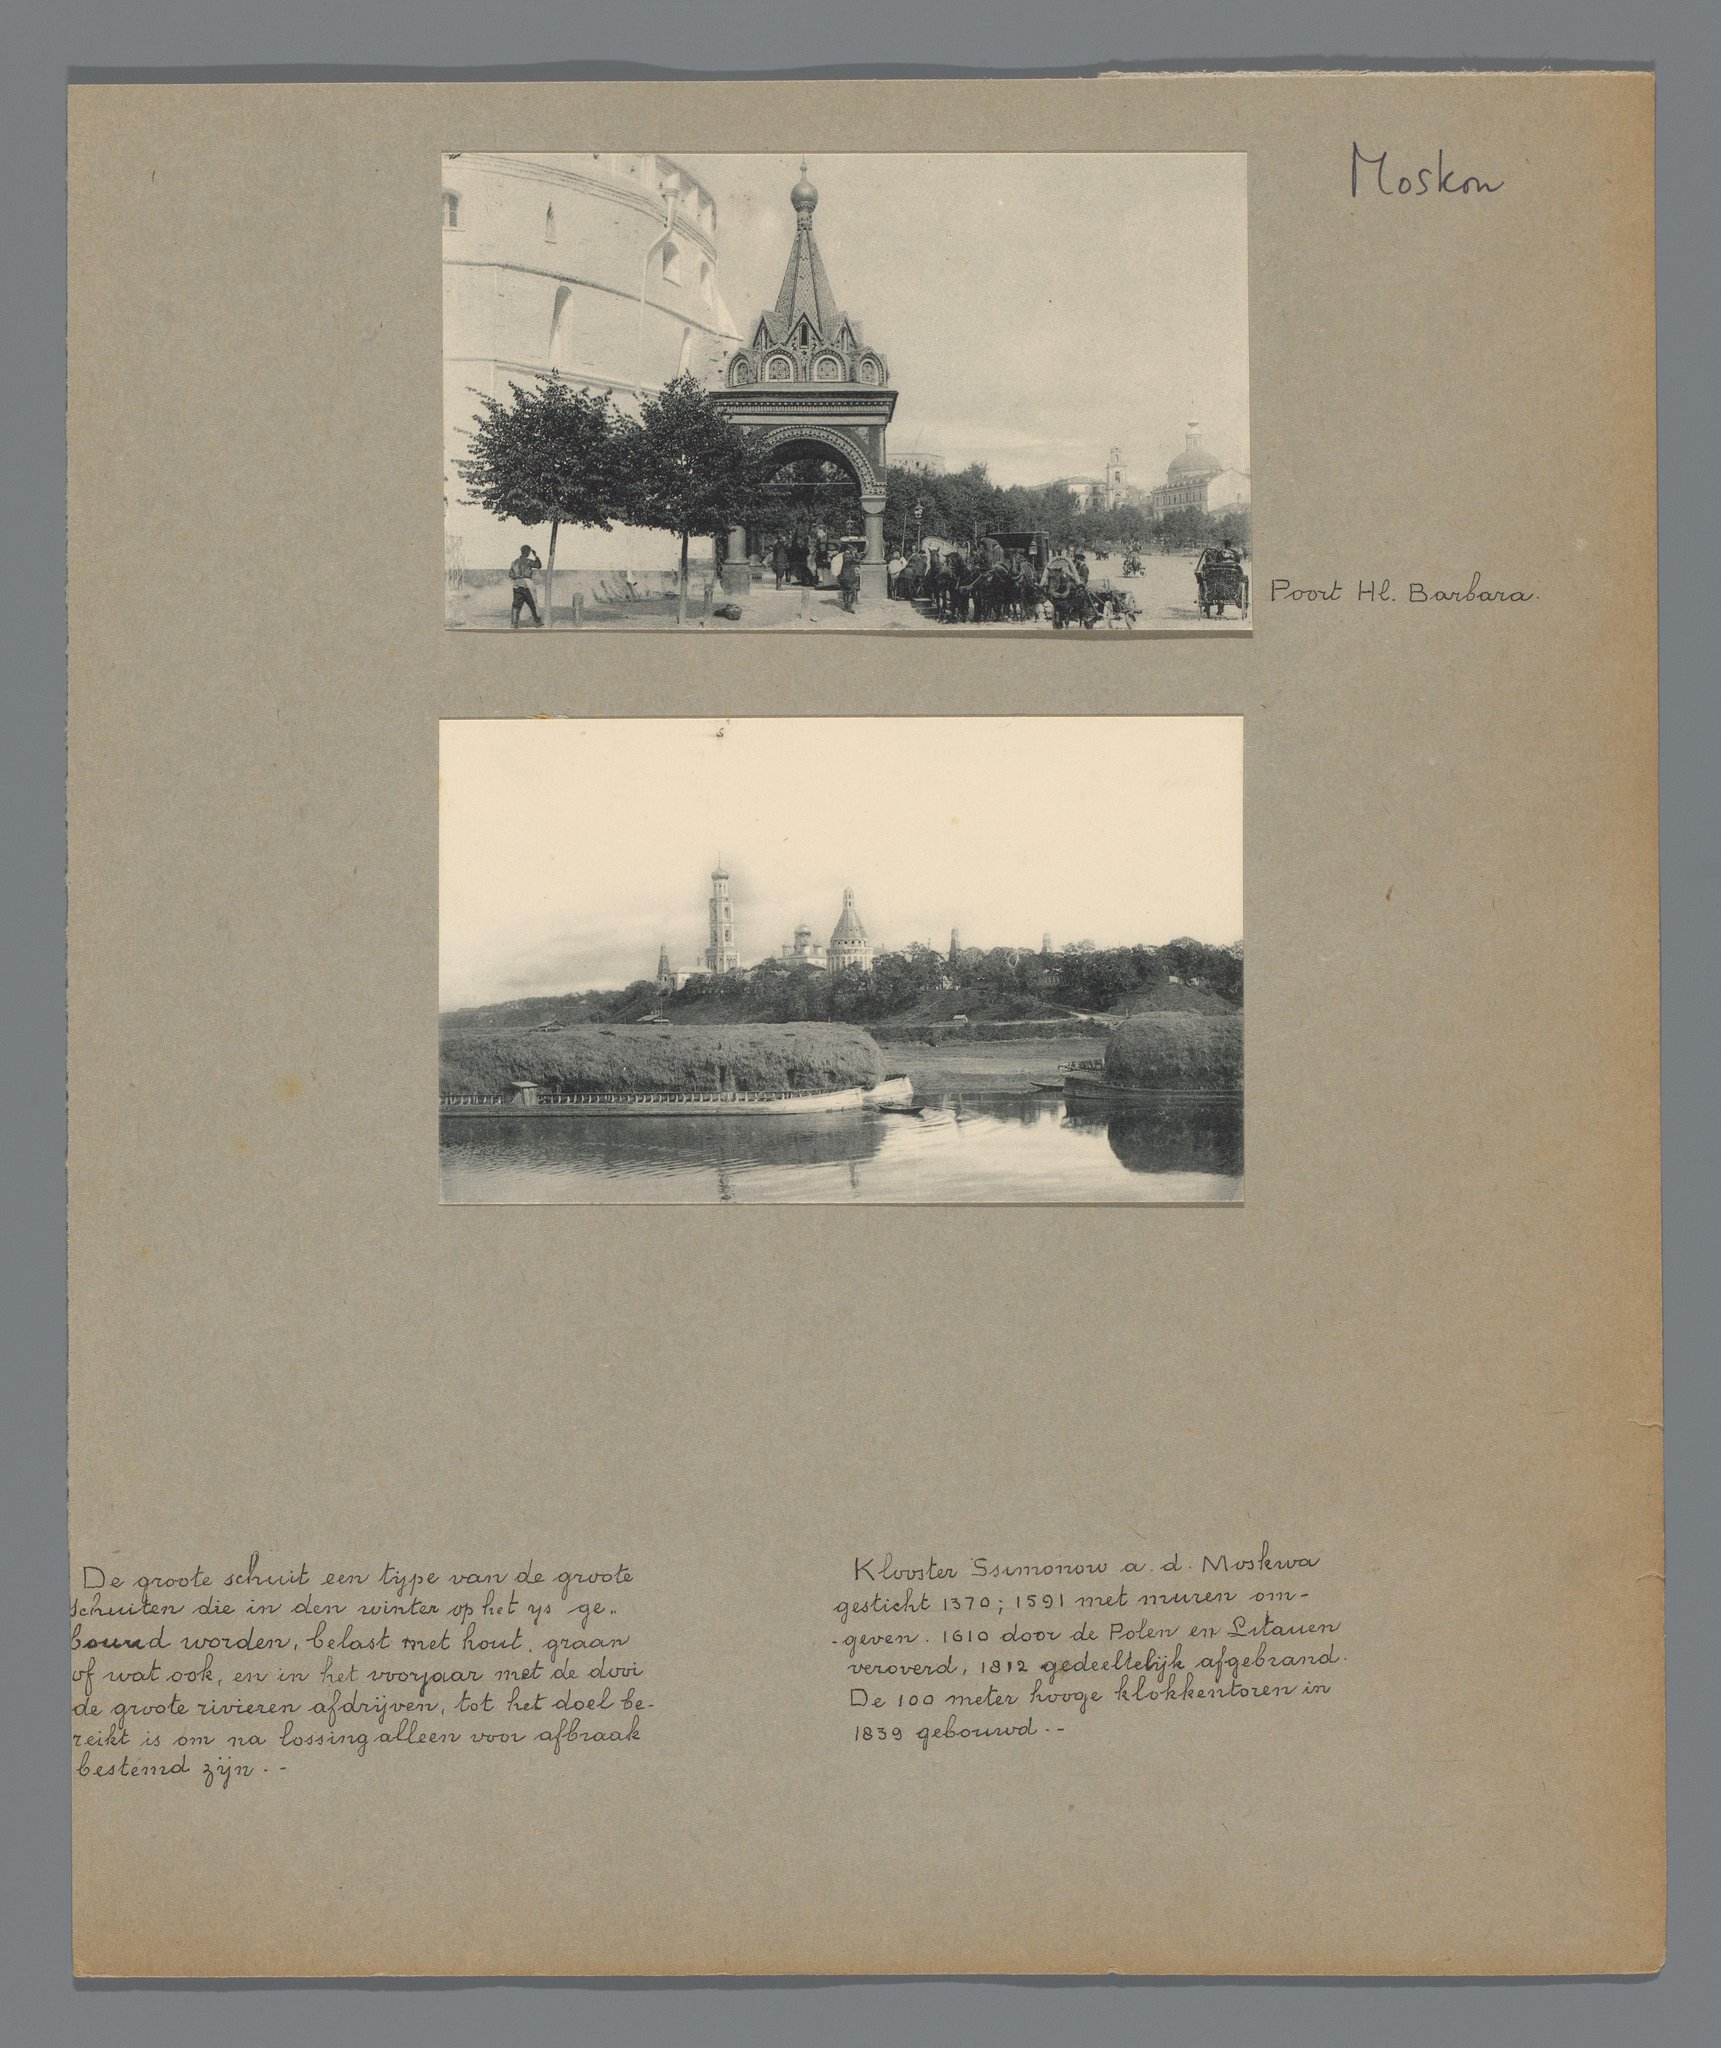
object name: photograph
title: Moskou. Poort Hl. Barbara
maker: Anonymous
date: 1860-1925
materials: photographic support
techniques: photograph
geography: russia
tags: aleksandr sergeevic puskin